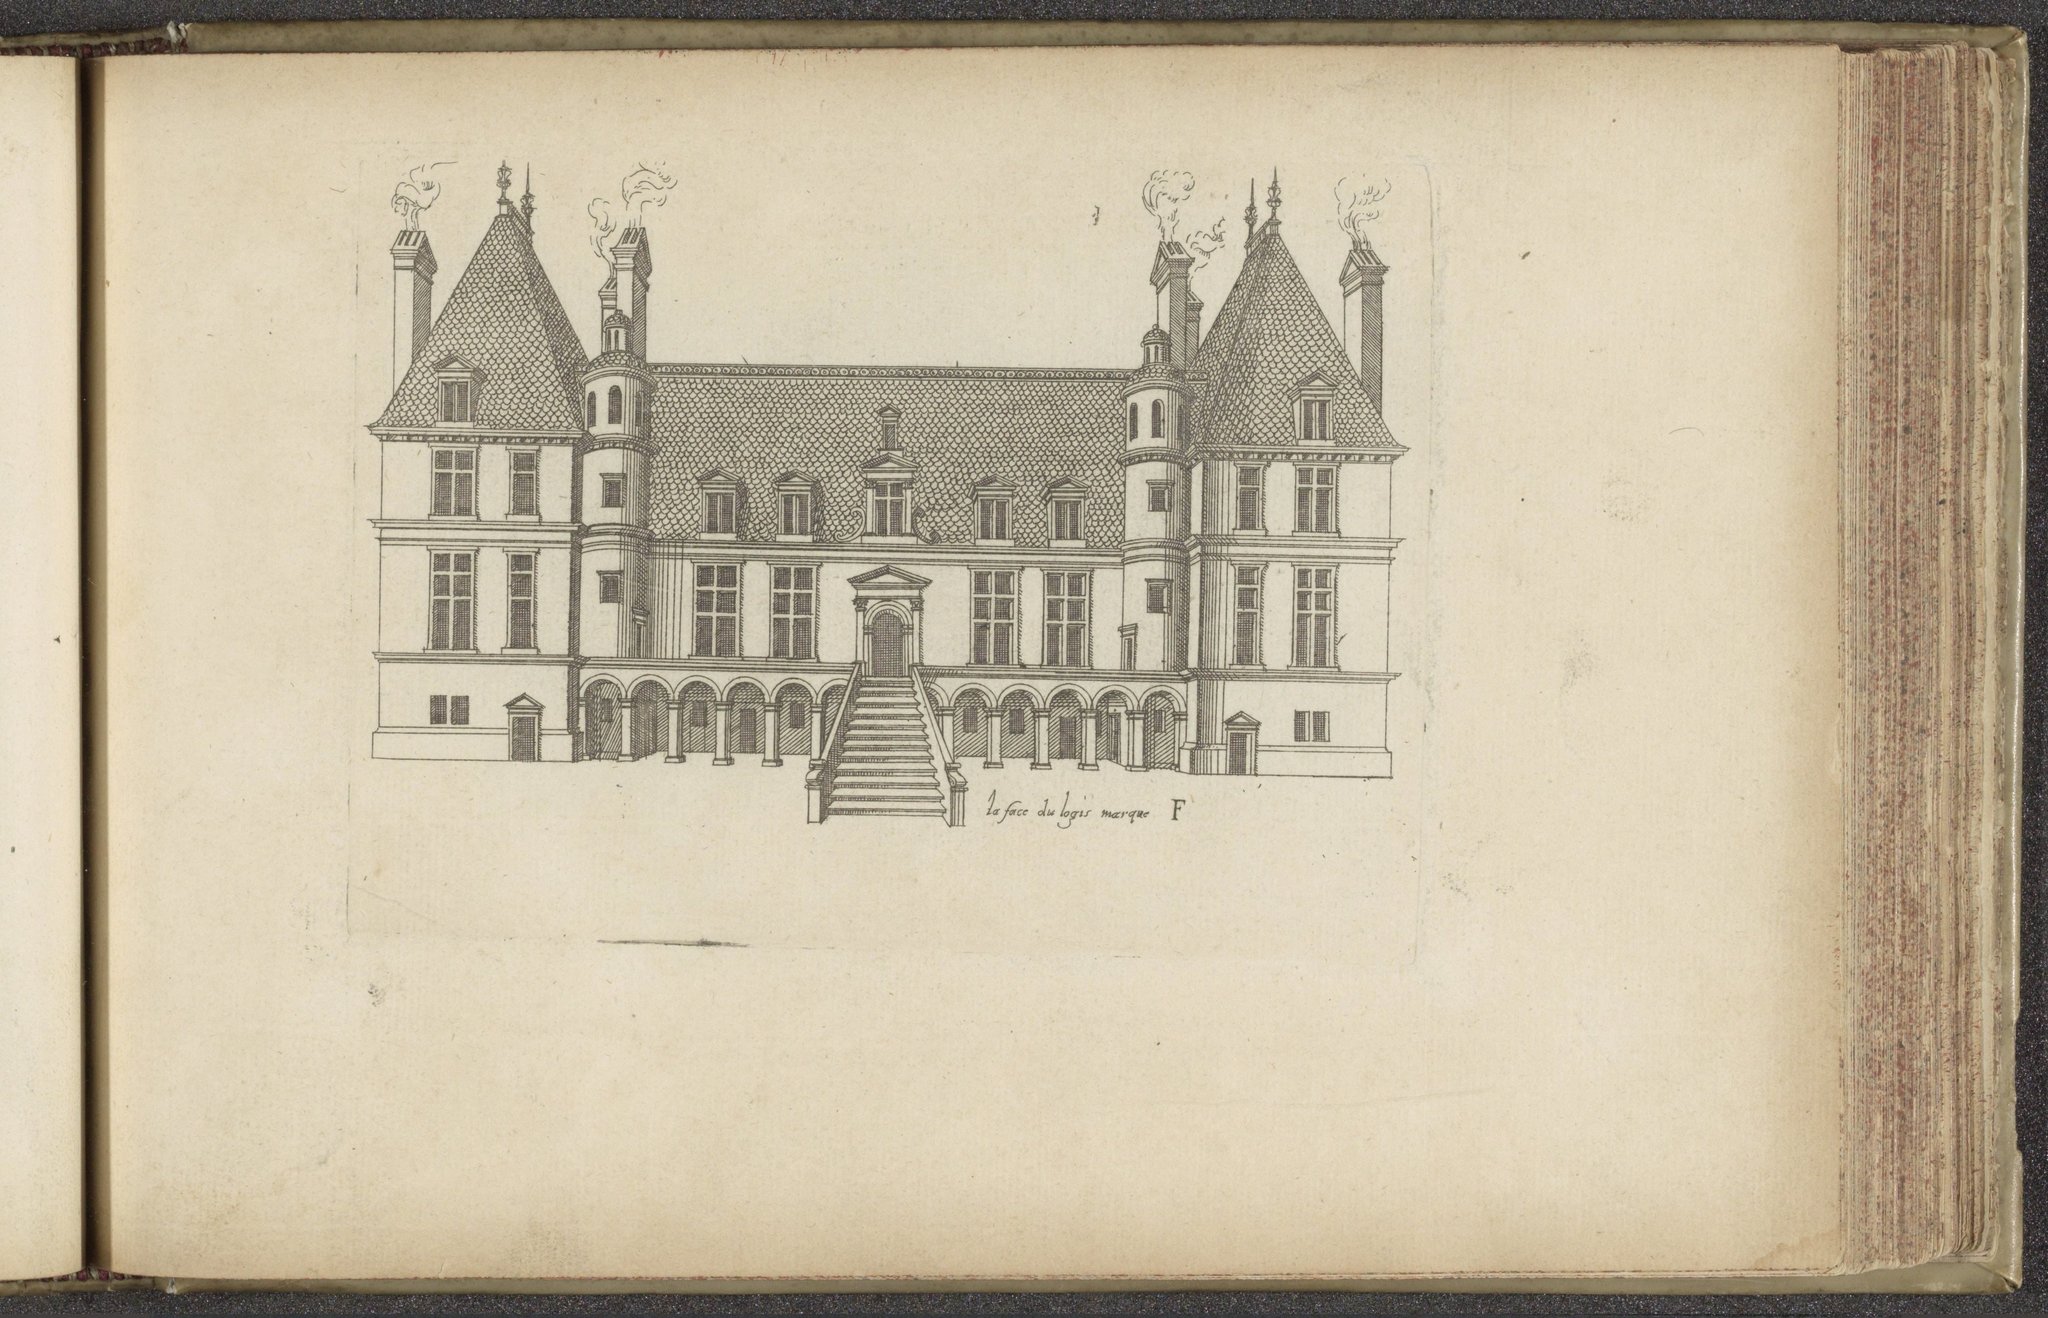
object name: album leaf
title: Vooraanzicht van landhuis F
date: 1540-1545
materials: paper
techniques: etching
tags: castle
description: Deze prent maakt deel uit van een album.